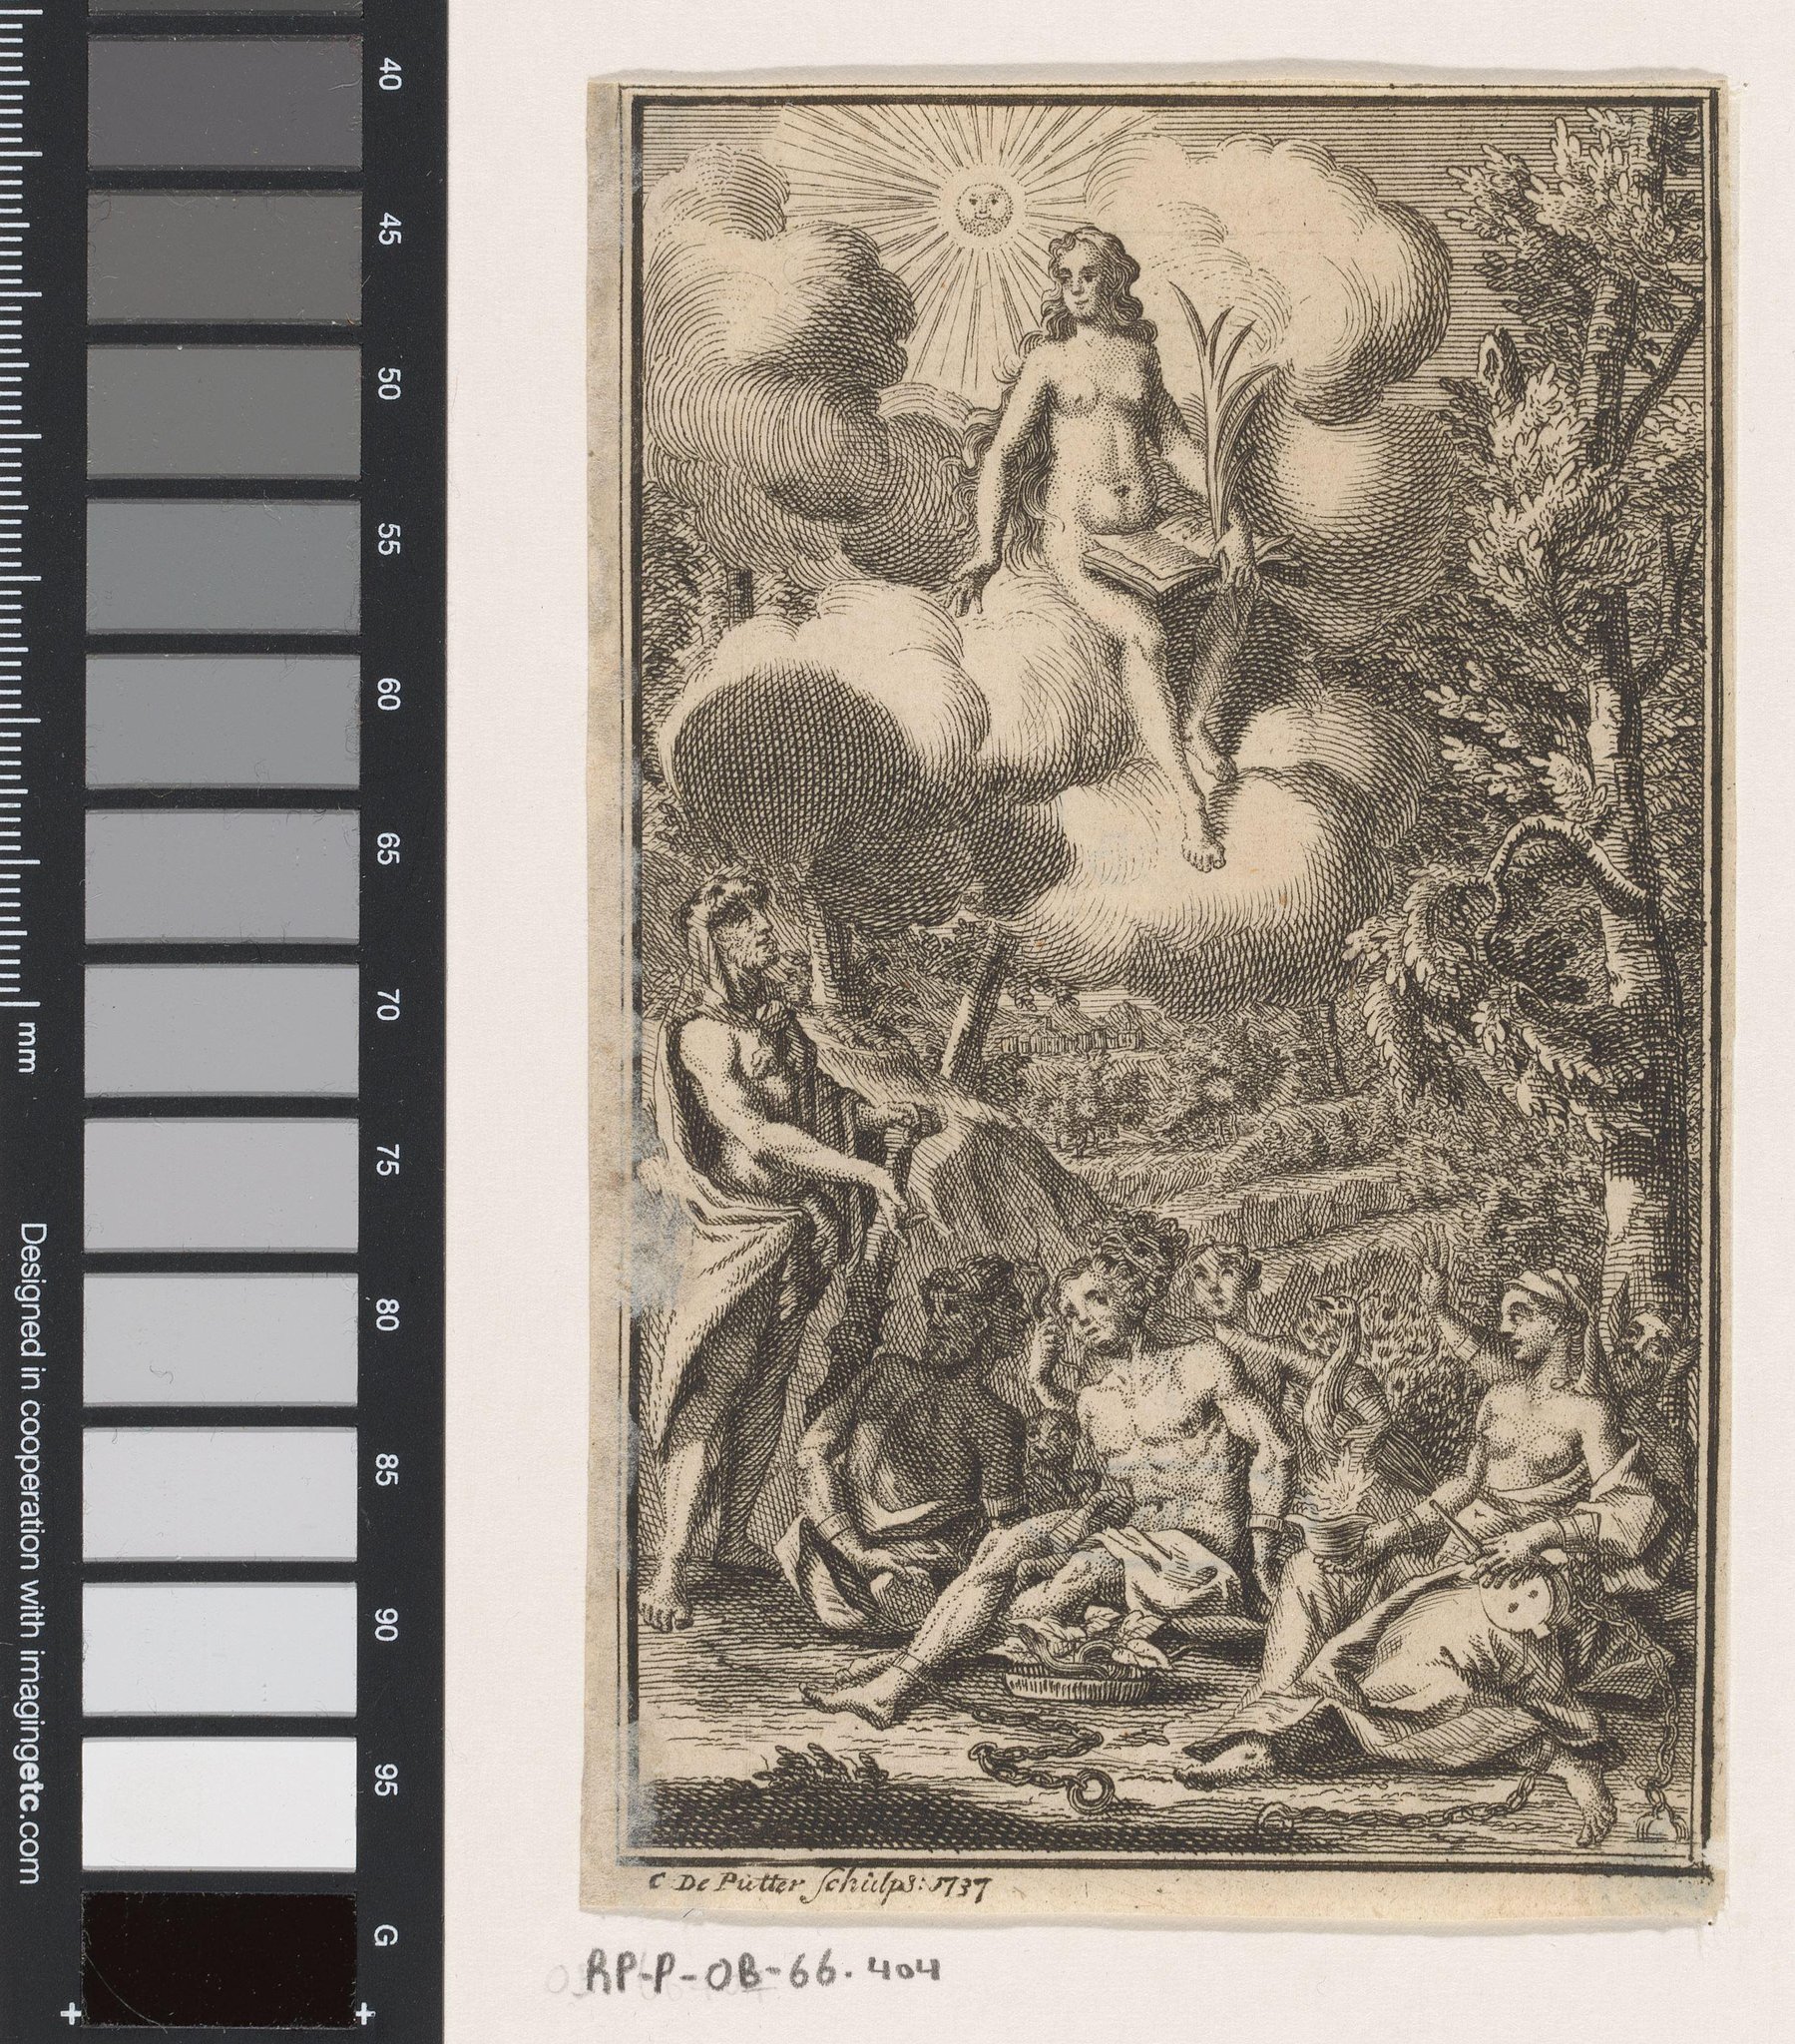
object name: print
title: Hercules en Waarheid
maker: coenraad de putter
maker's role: print maker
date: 1737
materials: paper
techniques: engraving, etching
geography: netherlands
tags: (story of) hercules (heracles), (story of) juno (hera), blasphemy, gorgons, truth; 'verità' (ripa), sun represented as face, wheel, etc., janus' head, two-faced head, (story of) midas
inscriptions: collector's mark: Lugt 2228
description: Hercules heeft verscheidene figuren geketend: Koning Midas (de man met de ezelsoren), Juno, een van de gorgonen, Janus (de man met twee gezichten), de personificatie van Kwaadsprekerij met haar blaasbalg en een andere figuur. Hij toont de geketende aan de personificatie van Waarheid, de naakte figuur op een wolk met een palmtak in de hand met de zon achter haar.